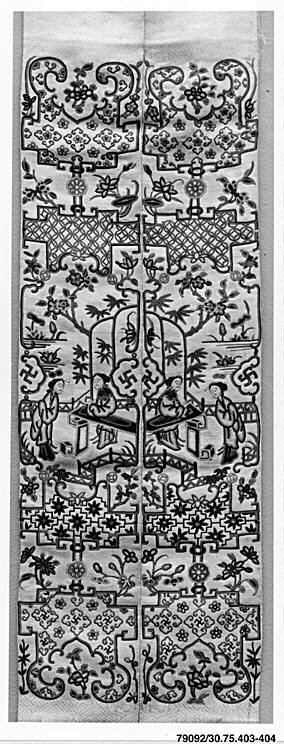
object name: sleeve band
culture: chinese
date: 1801-1900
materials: metal thread, silk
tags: human figures,flowers